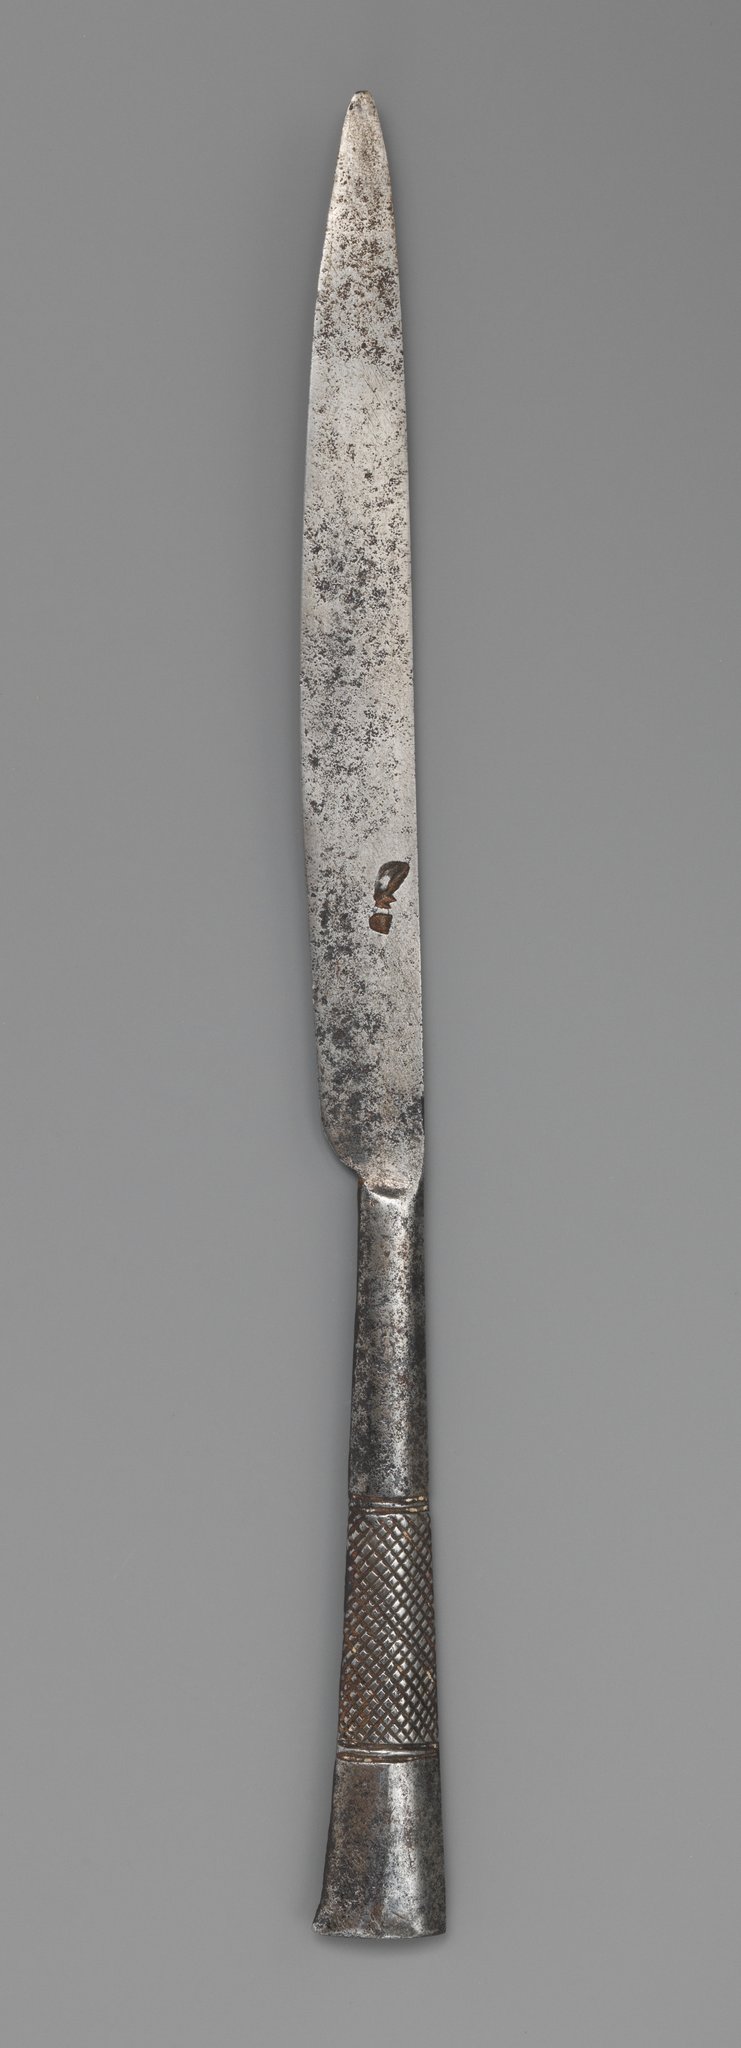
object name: table knife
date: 1601-1700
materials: steel